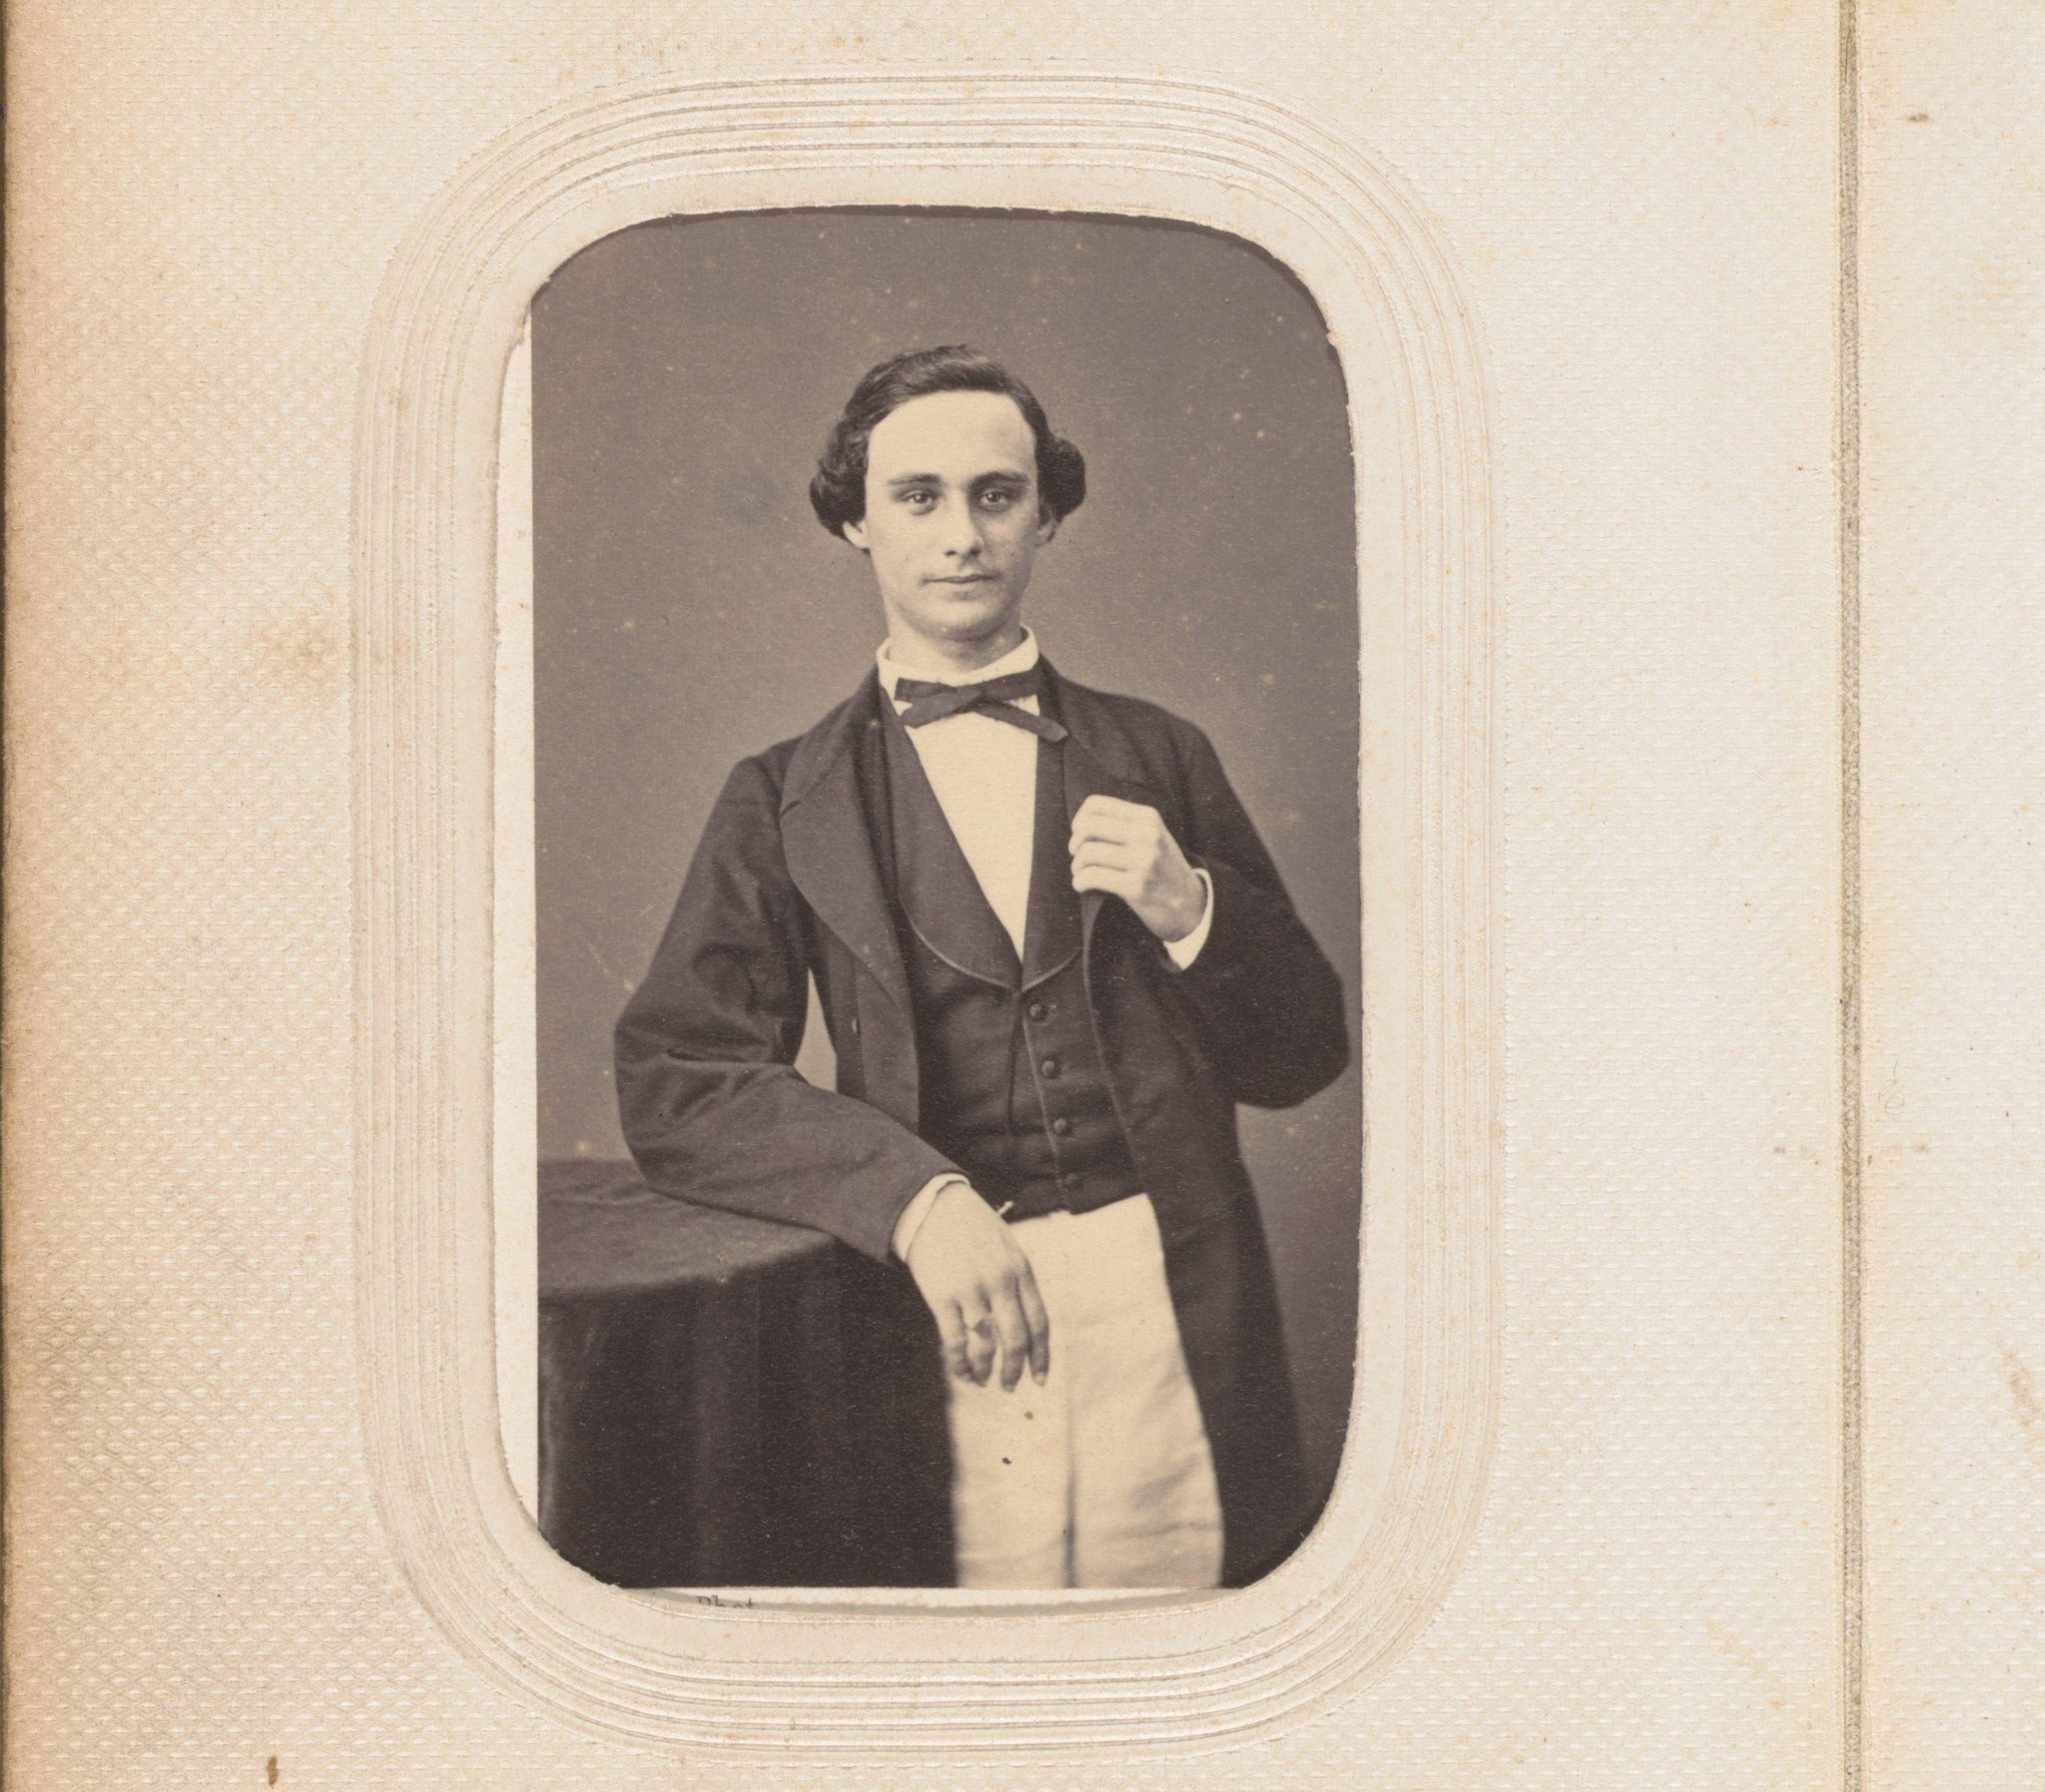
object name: photograph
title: Portret van een staande jongeman met vlinderdasje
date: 1855-1865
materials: cardboard, photographic support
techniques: albumen print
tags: historical persons, youth, adolescent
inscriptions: inscription: ‘3 Rue Mautrec, Bordeaux’